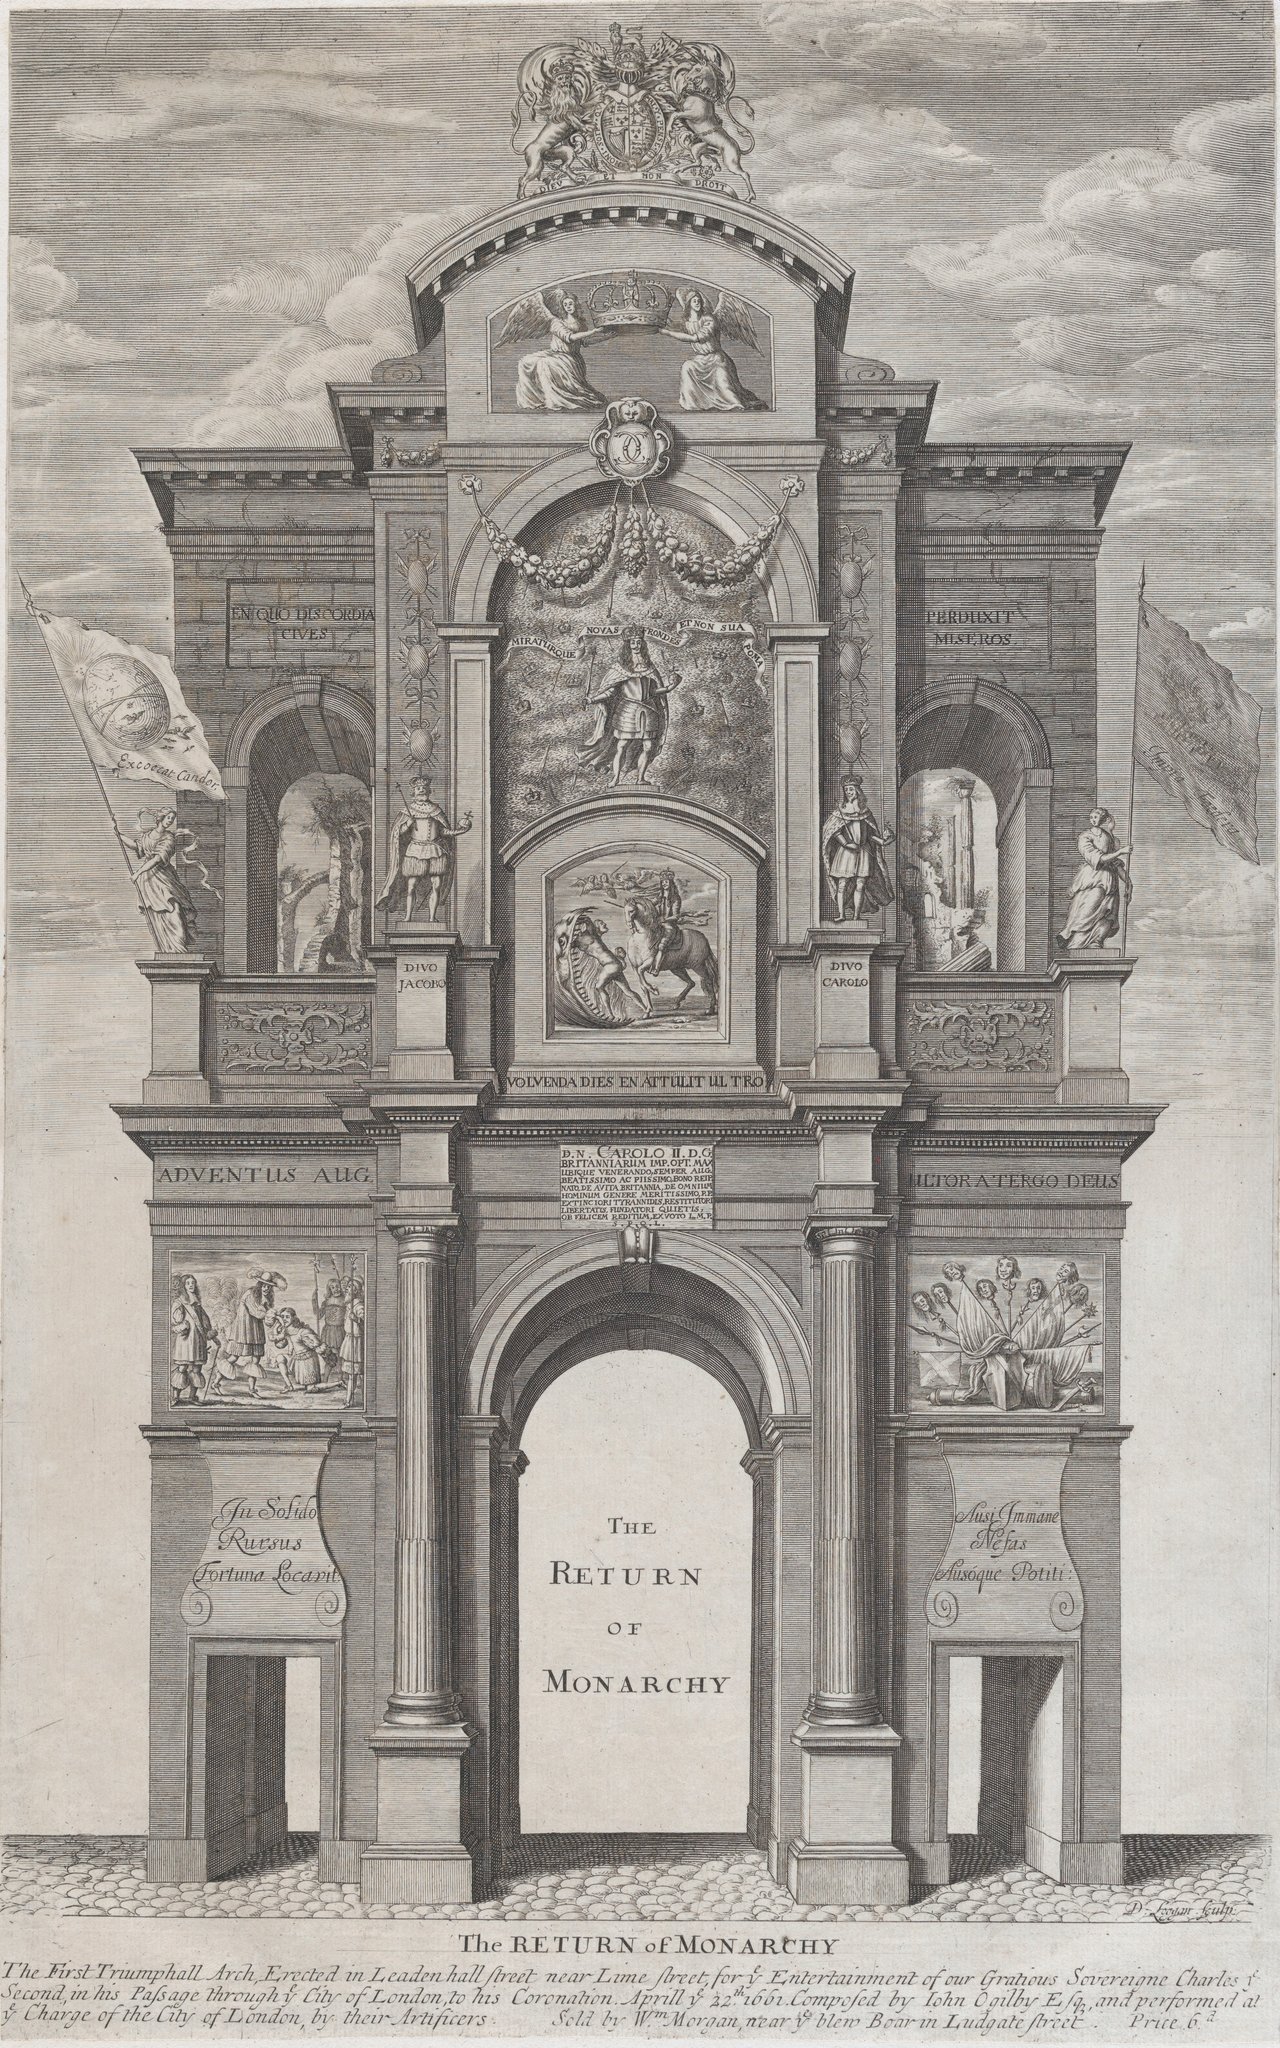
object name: print, fete, ornament architecture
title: The Return of Monarchy; the first triumphal arch erected for Charles II in his passage through the city of London for his coronation, April 22, 1661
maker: david loggan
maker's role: artist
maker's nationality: british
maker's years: 1634-1692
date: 1662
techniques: engraving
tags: architecture,arches